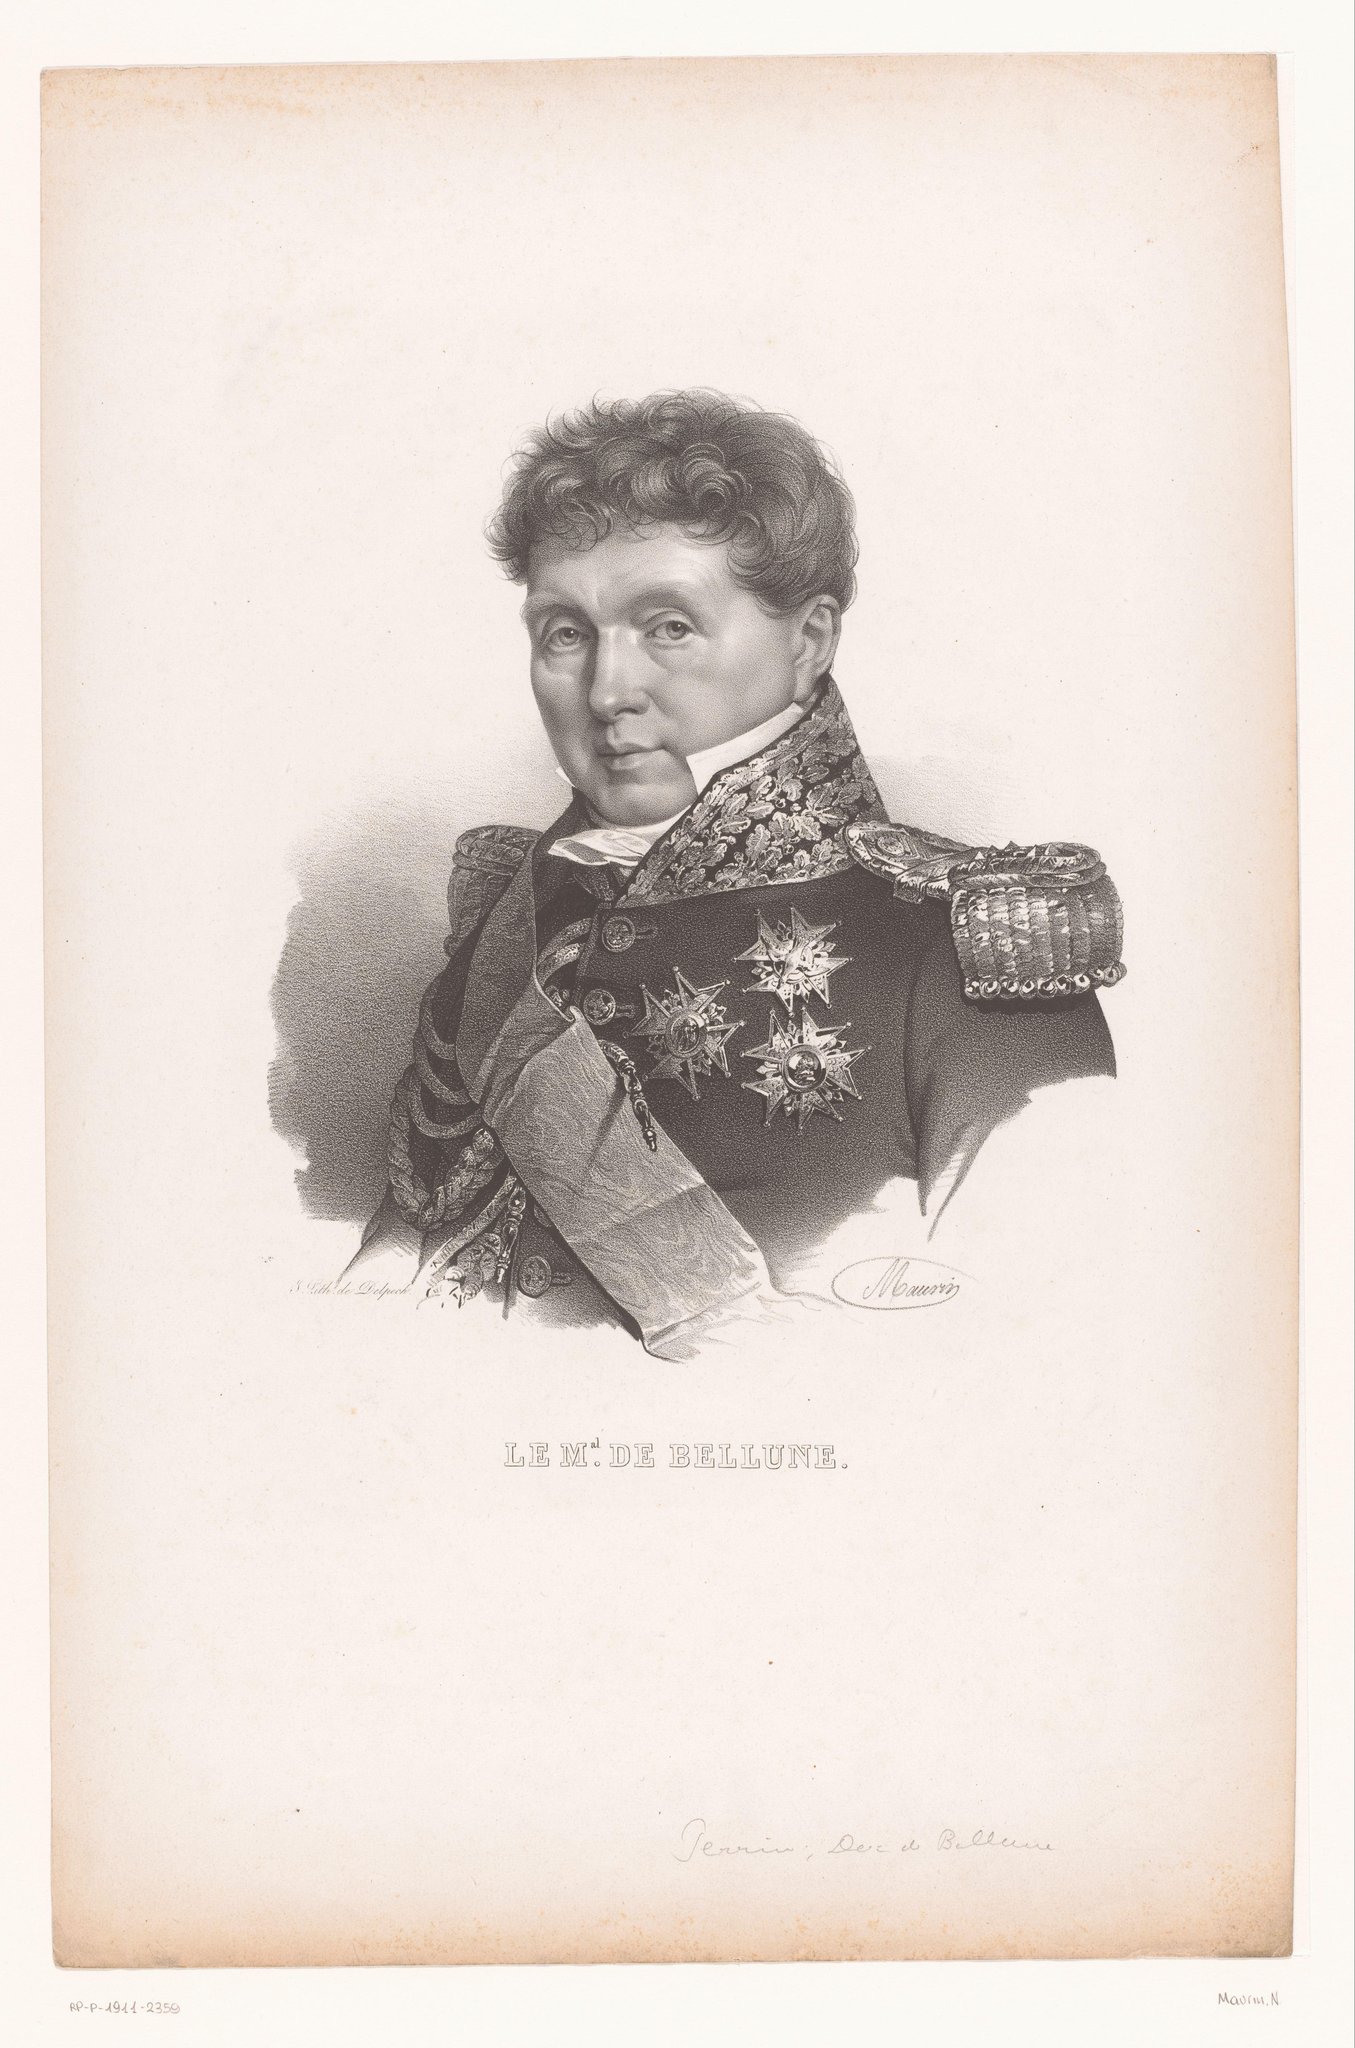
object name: print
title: Le mal. de Bellune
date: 1825-1842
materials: paper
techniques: lithograph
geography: paris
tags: paris, commander-in-chief, general, marshal, historical persons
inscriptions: collector's mark: Lugt 2228